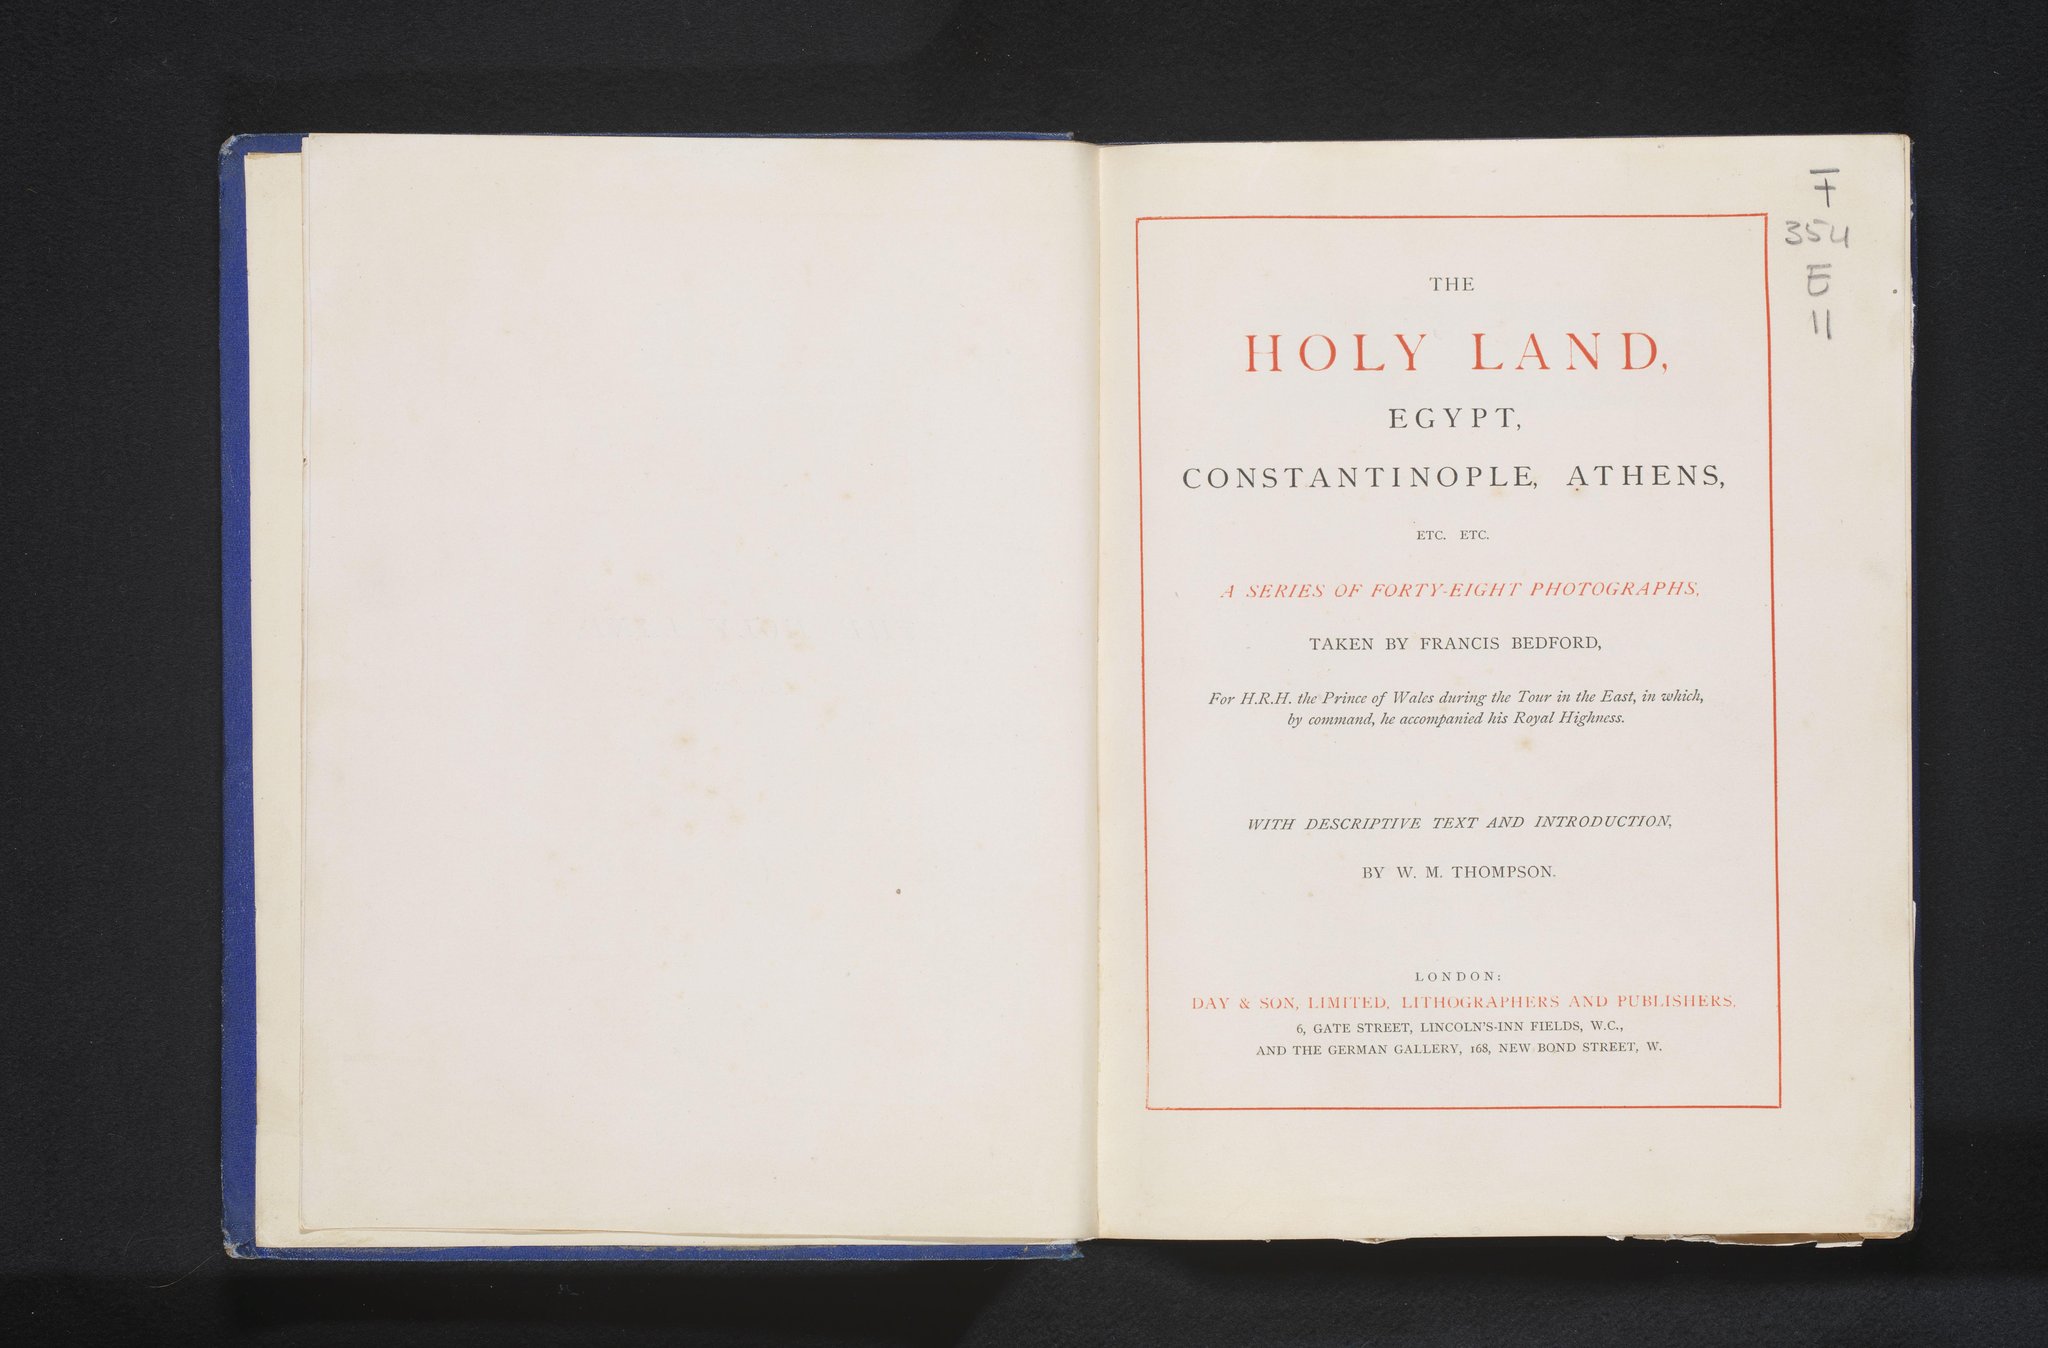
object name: book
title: The Holy Land, Egypt, Constantinopel, Athens, etc. etc.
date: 1866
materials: cardboard, linen, paper, photographic support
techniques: albumen print, printing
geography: london